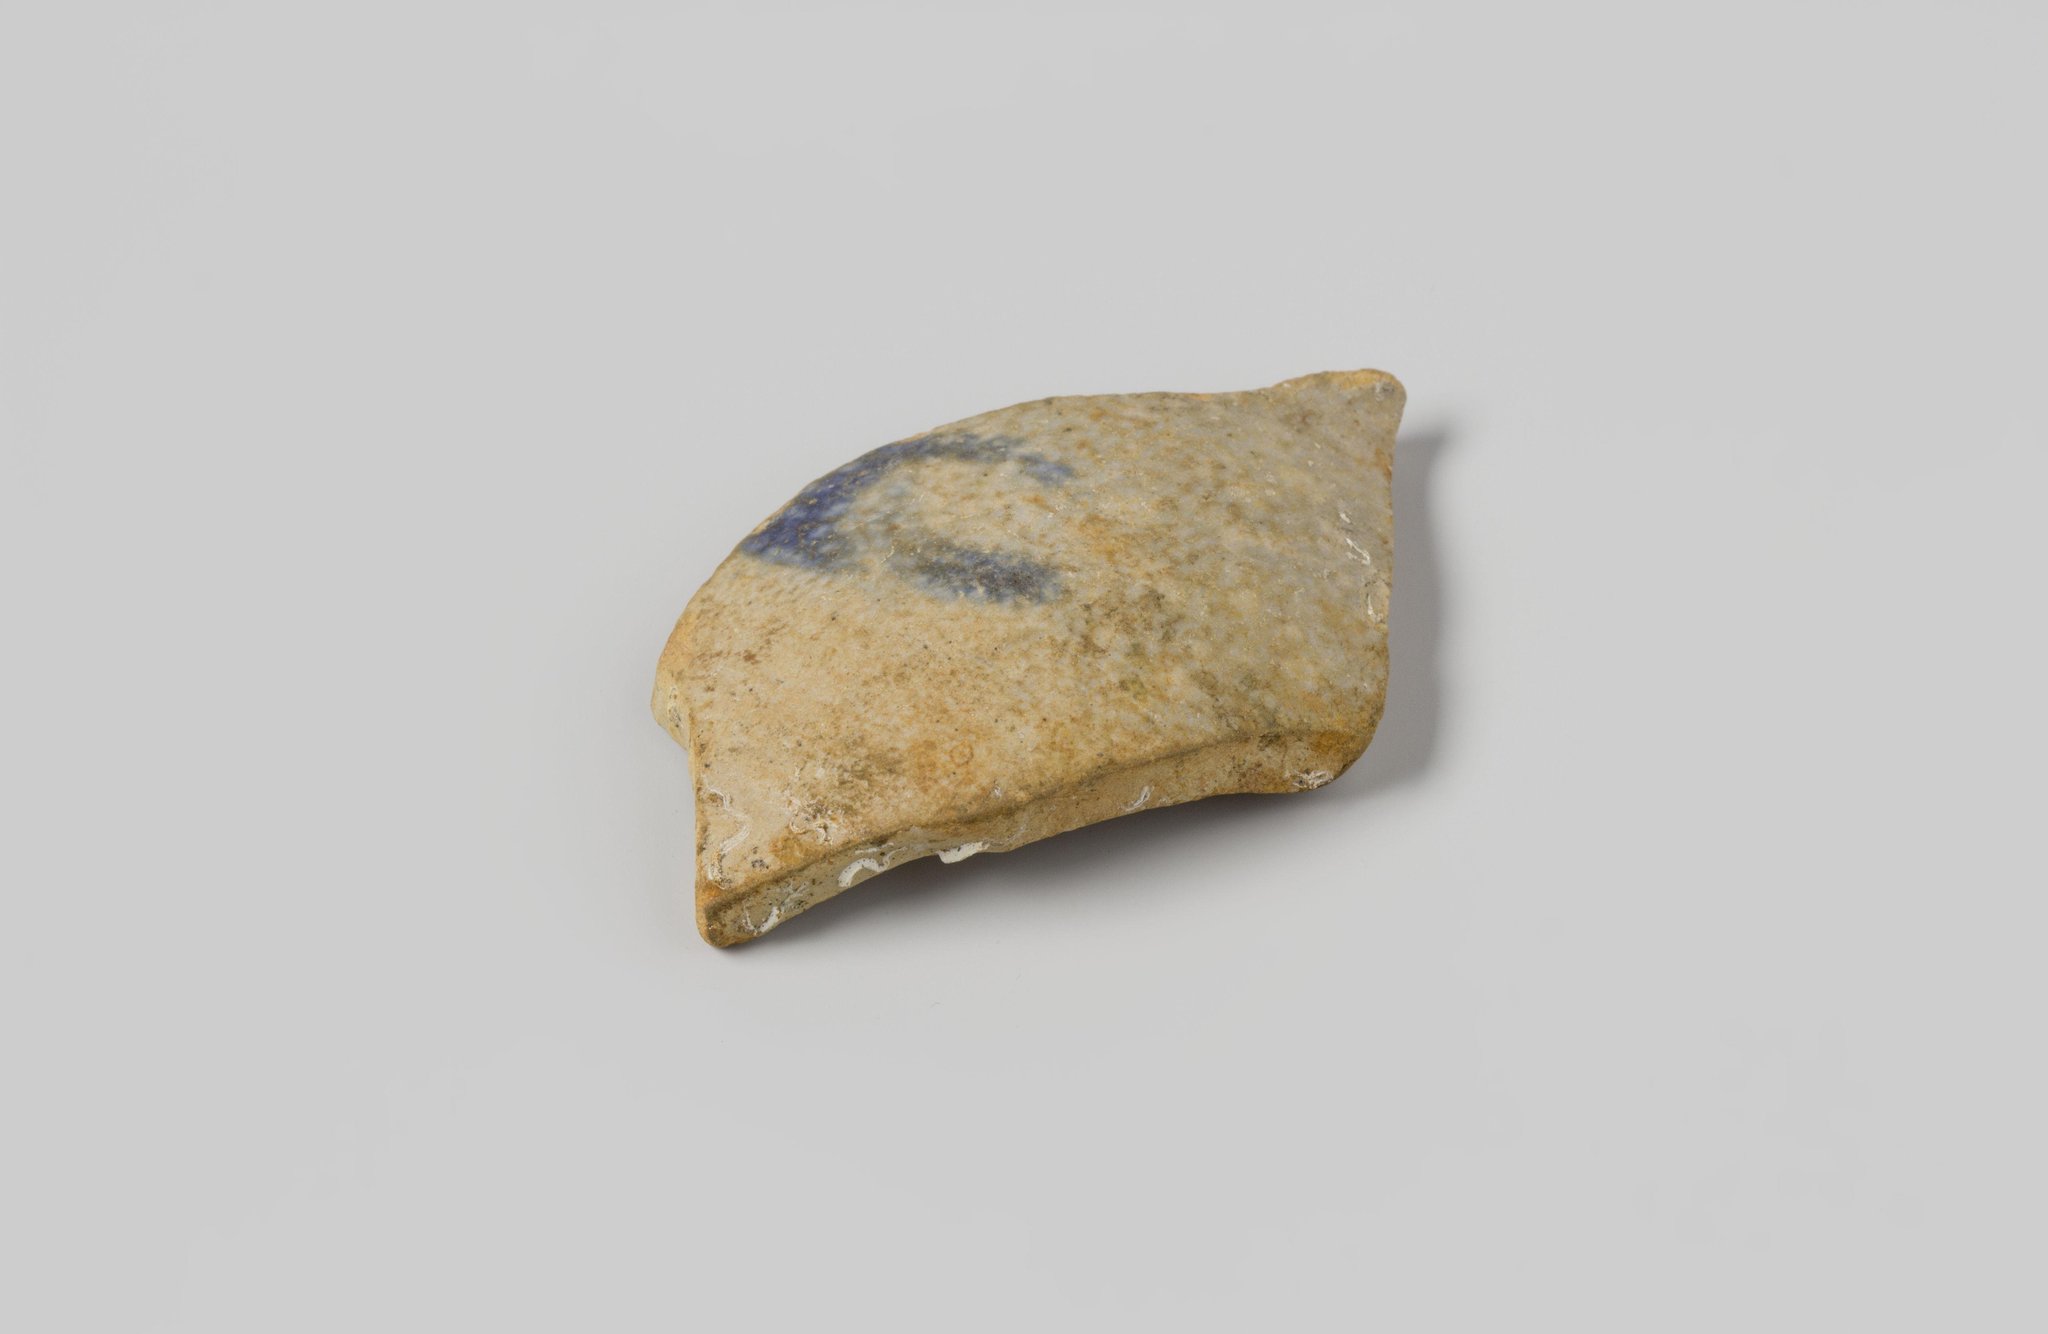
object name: sherd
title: Scherf van een kan uit het wrak van de Oost-Indiëvaarder Hollandia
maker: Anonymous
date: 1700-1743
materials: stoneware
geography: westerwald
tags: verenigde oostindische compagnie, hollandia (schip), annet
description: Stoneware, Rhenish, Westerwald, jug; fragm of body with traces of blue paint, sim. NG 1980-27H2615.